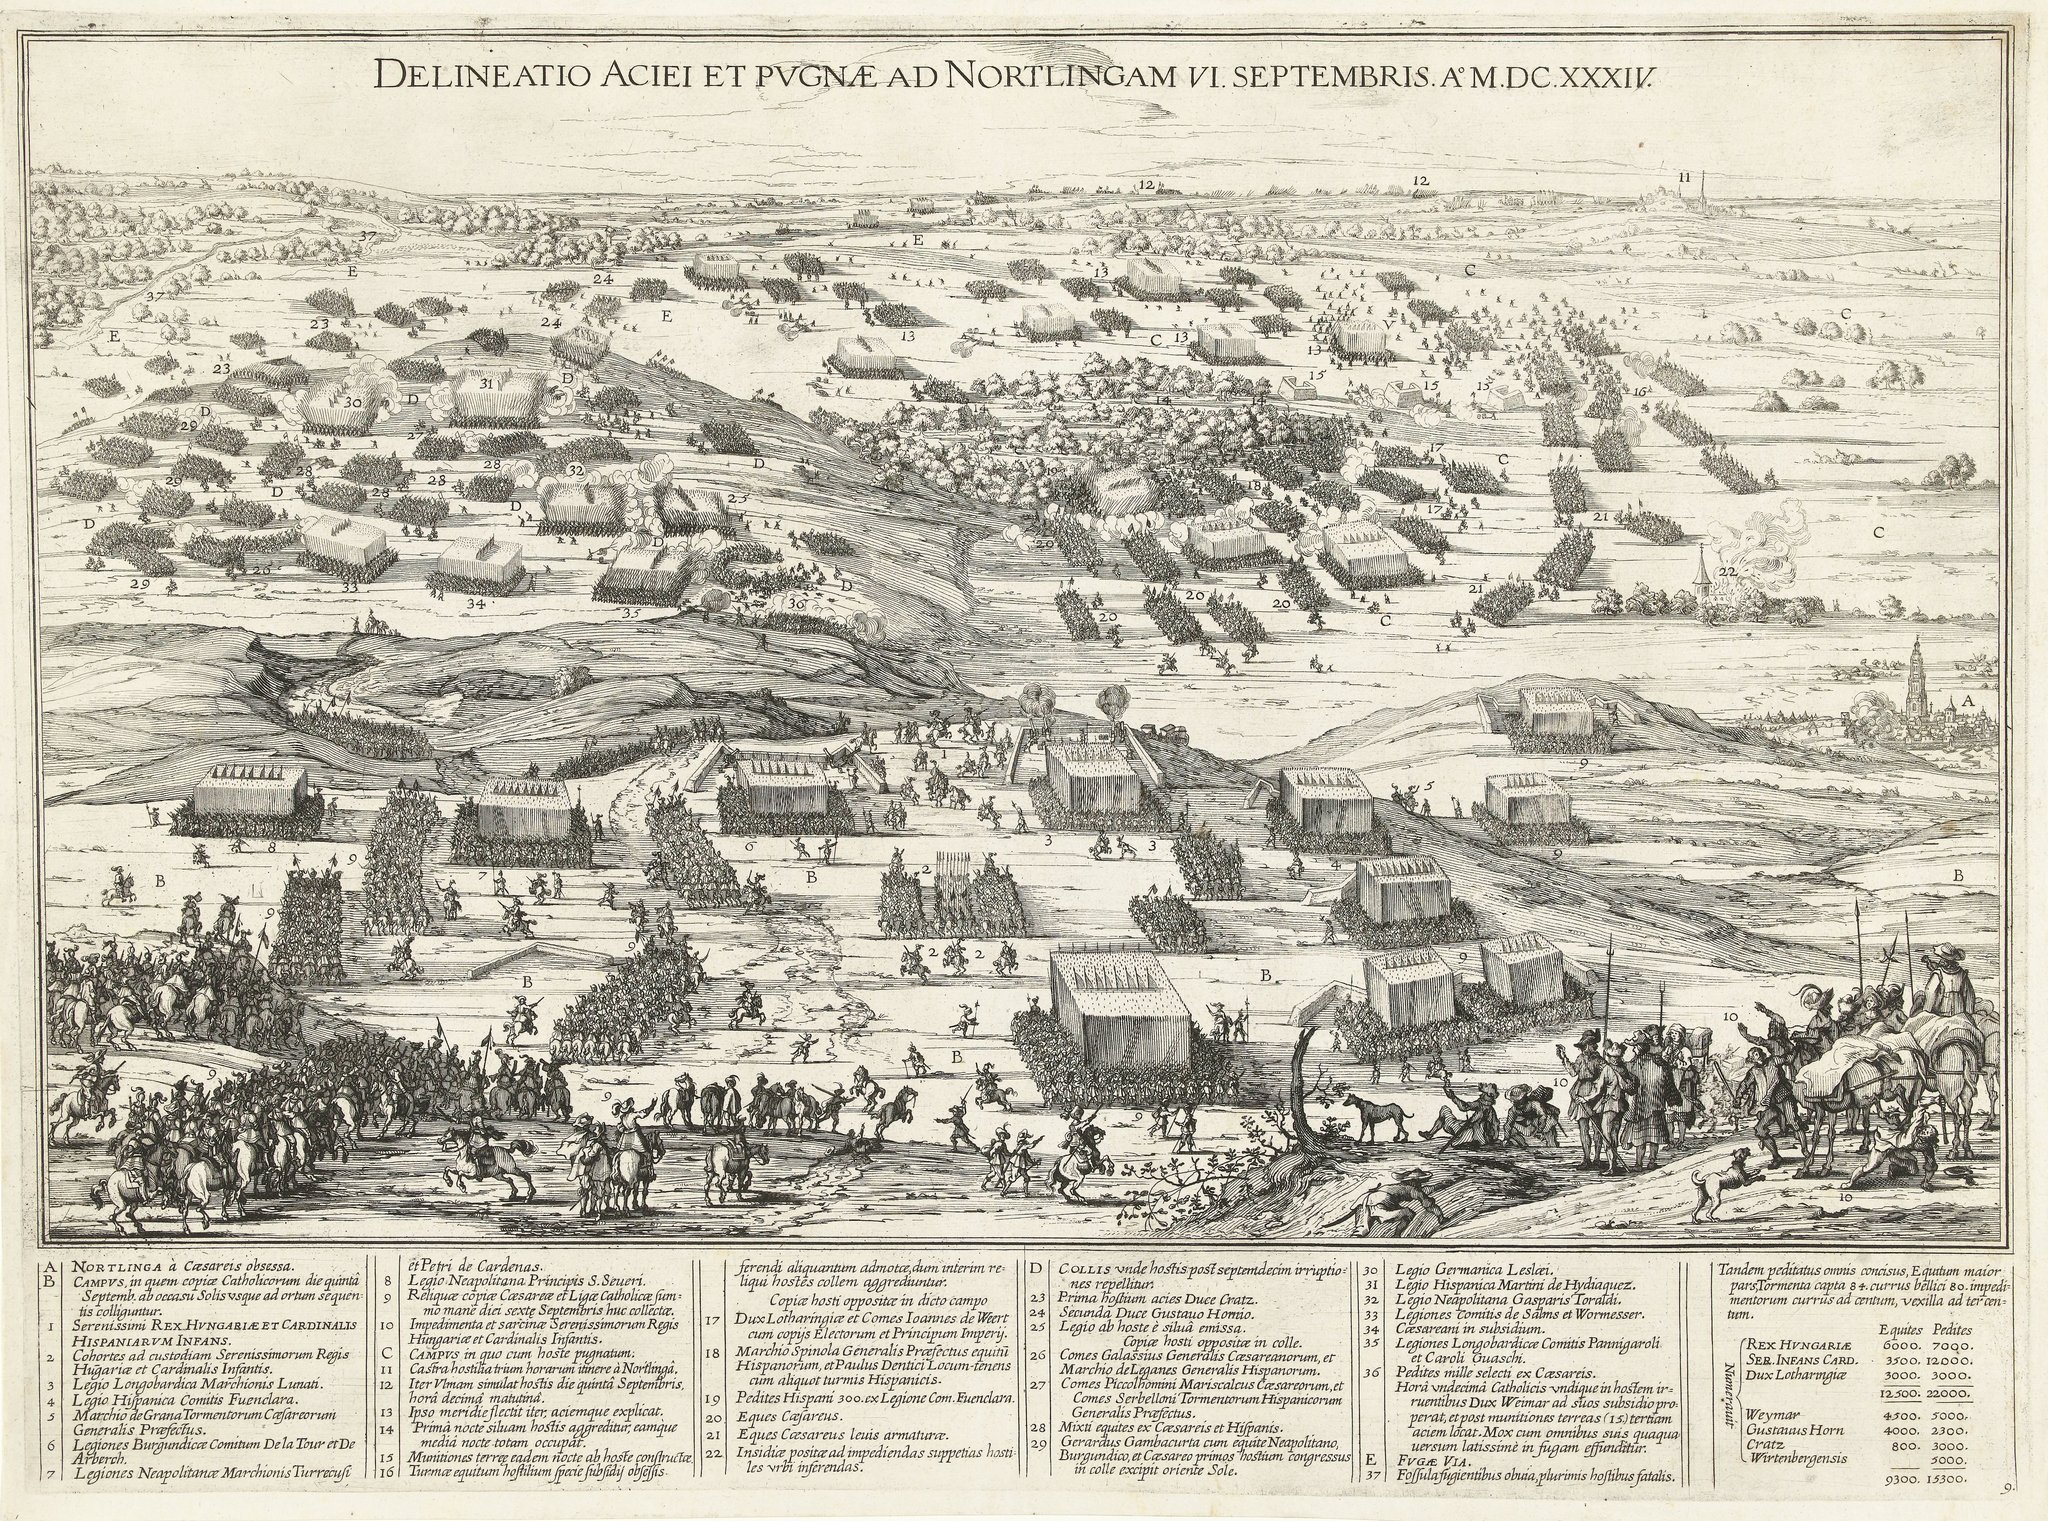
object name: print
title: Battle of Nördlingen, 1634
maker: balthasar florisz. van berckenrode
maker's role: draughtsman, print maker, publisher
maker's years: 1591-1645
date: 1634-1636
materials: paper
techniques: etching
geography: northern netherlands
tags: vienna, ferdinand iii (duits keizer), battle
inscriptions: collector's mark: Lugt 240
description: De belegering en verovering van de Beierse stad Nördlingen door het Habsburgse leger onder leiding van Ferdinand van Hongarije. Gevecht tegen de Zweedse troepen onder leiding van Bernard van Saksen. Onder de voorstelling een legenda van A-E en 1-37. Bij 1 koning Ferdinand van Hongarije te paard.